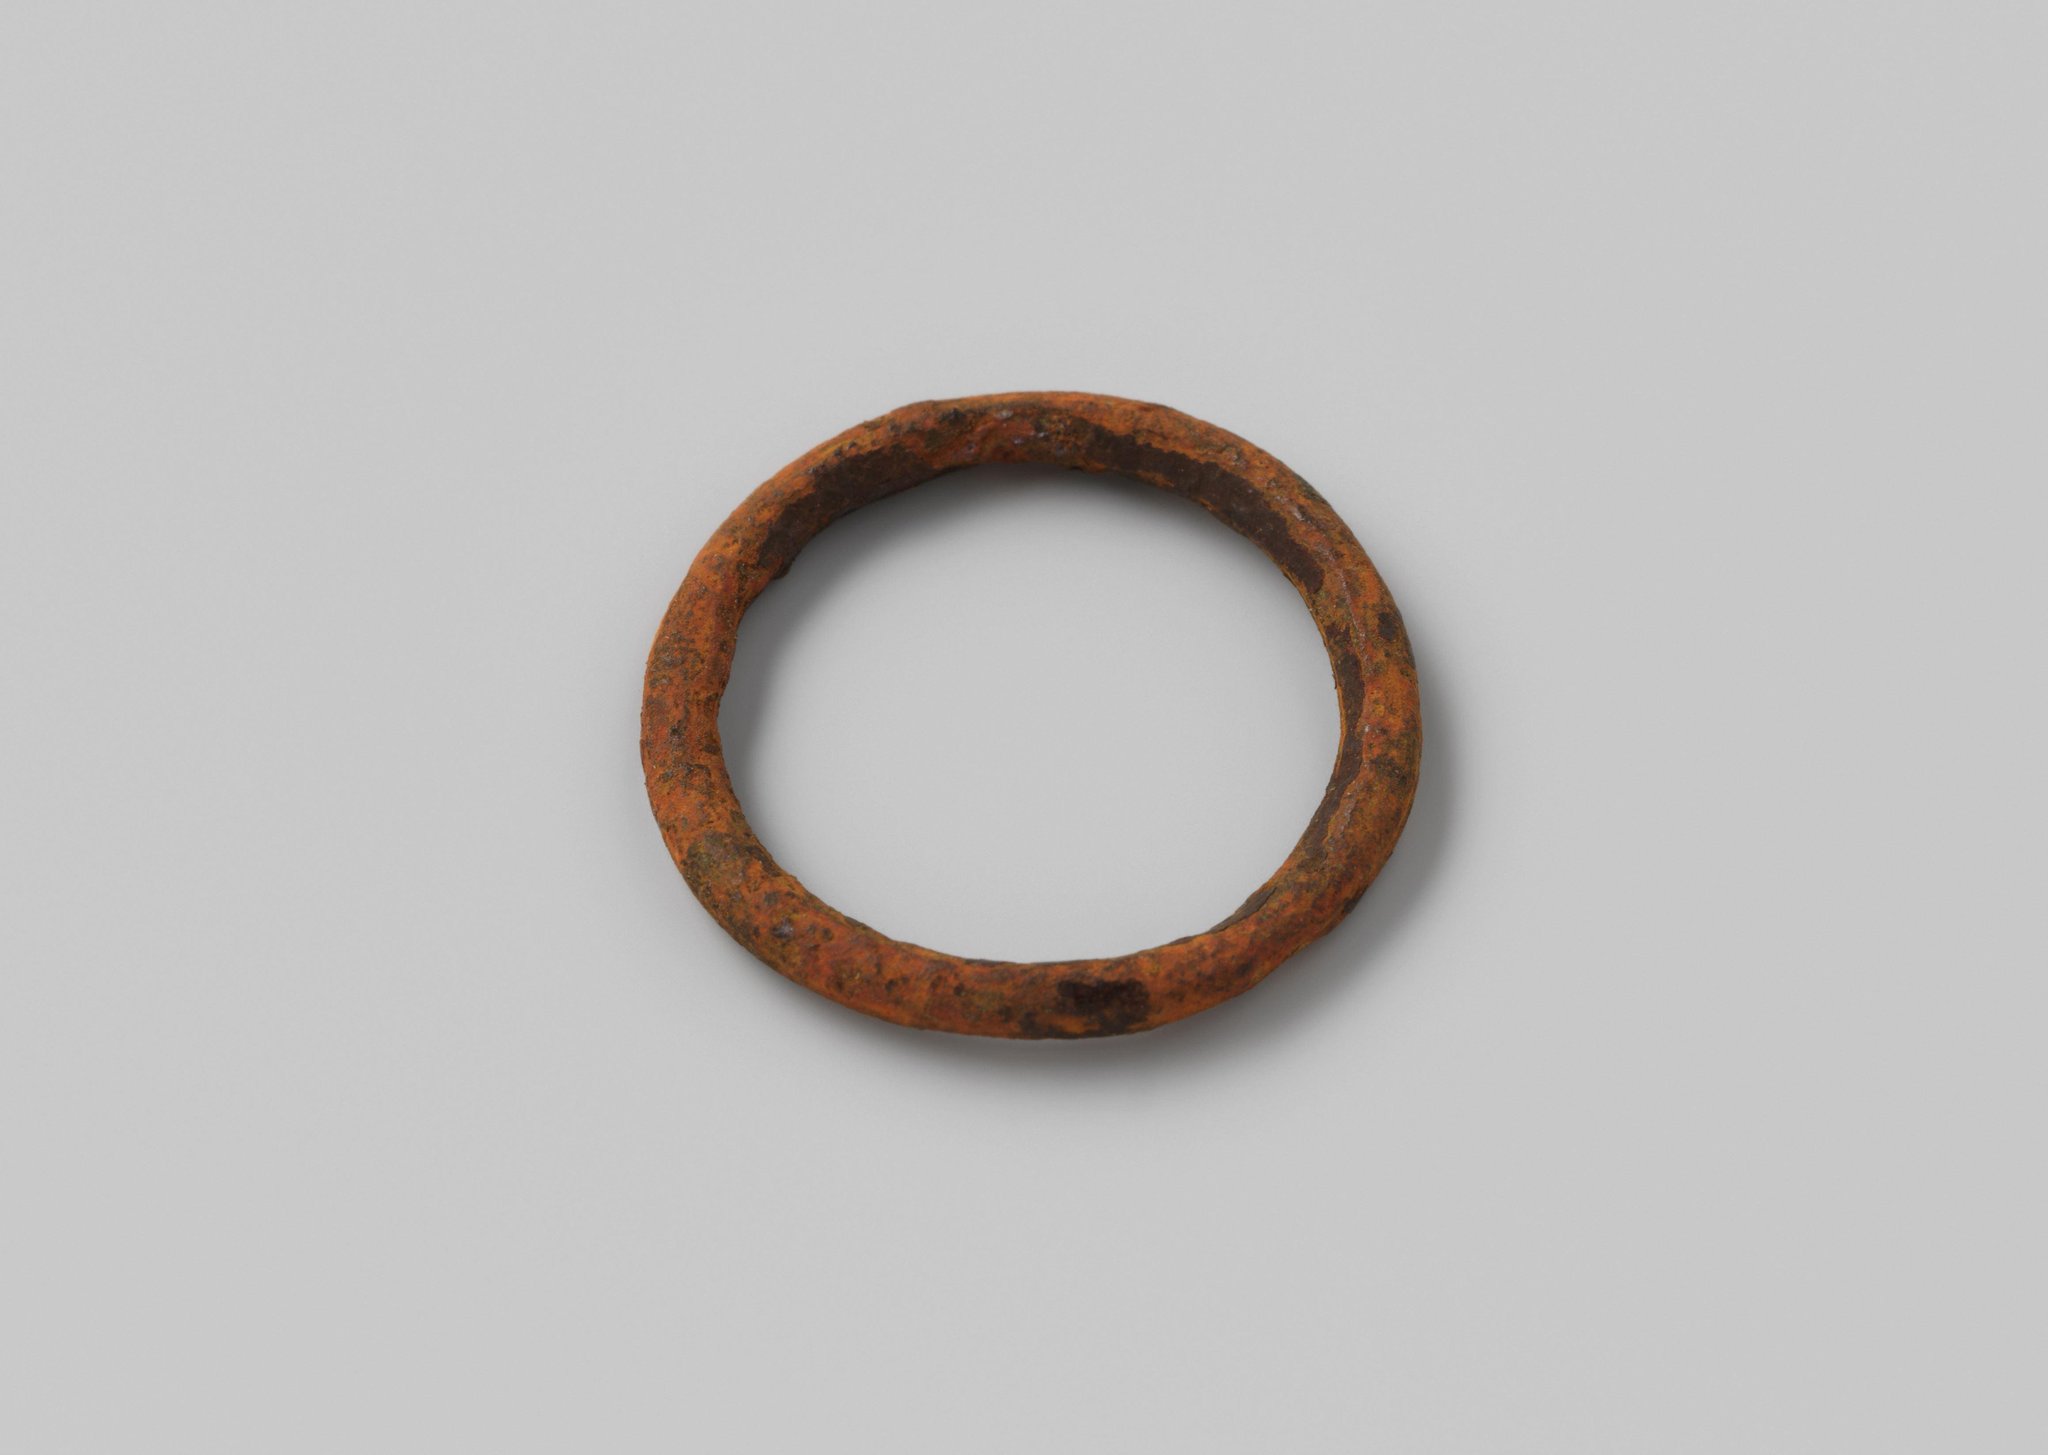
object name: fragment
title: Ringvormig fragment uit het wrak van de Oost-Indiëvaarder Hollandia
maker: Anonymous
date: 1700-1743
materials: copper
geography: netherlands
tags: verenigde oostindische compagnie, hollandia (schip), annet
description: Varied parts or fragments, rings or ring-shaped fragments; id. 80H625.